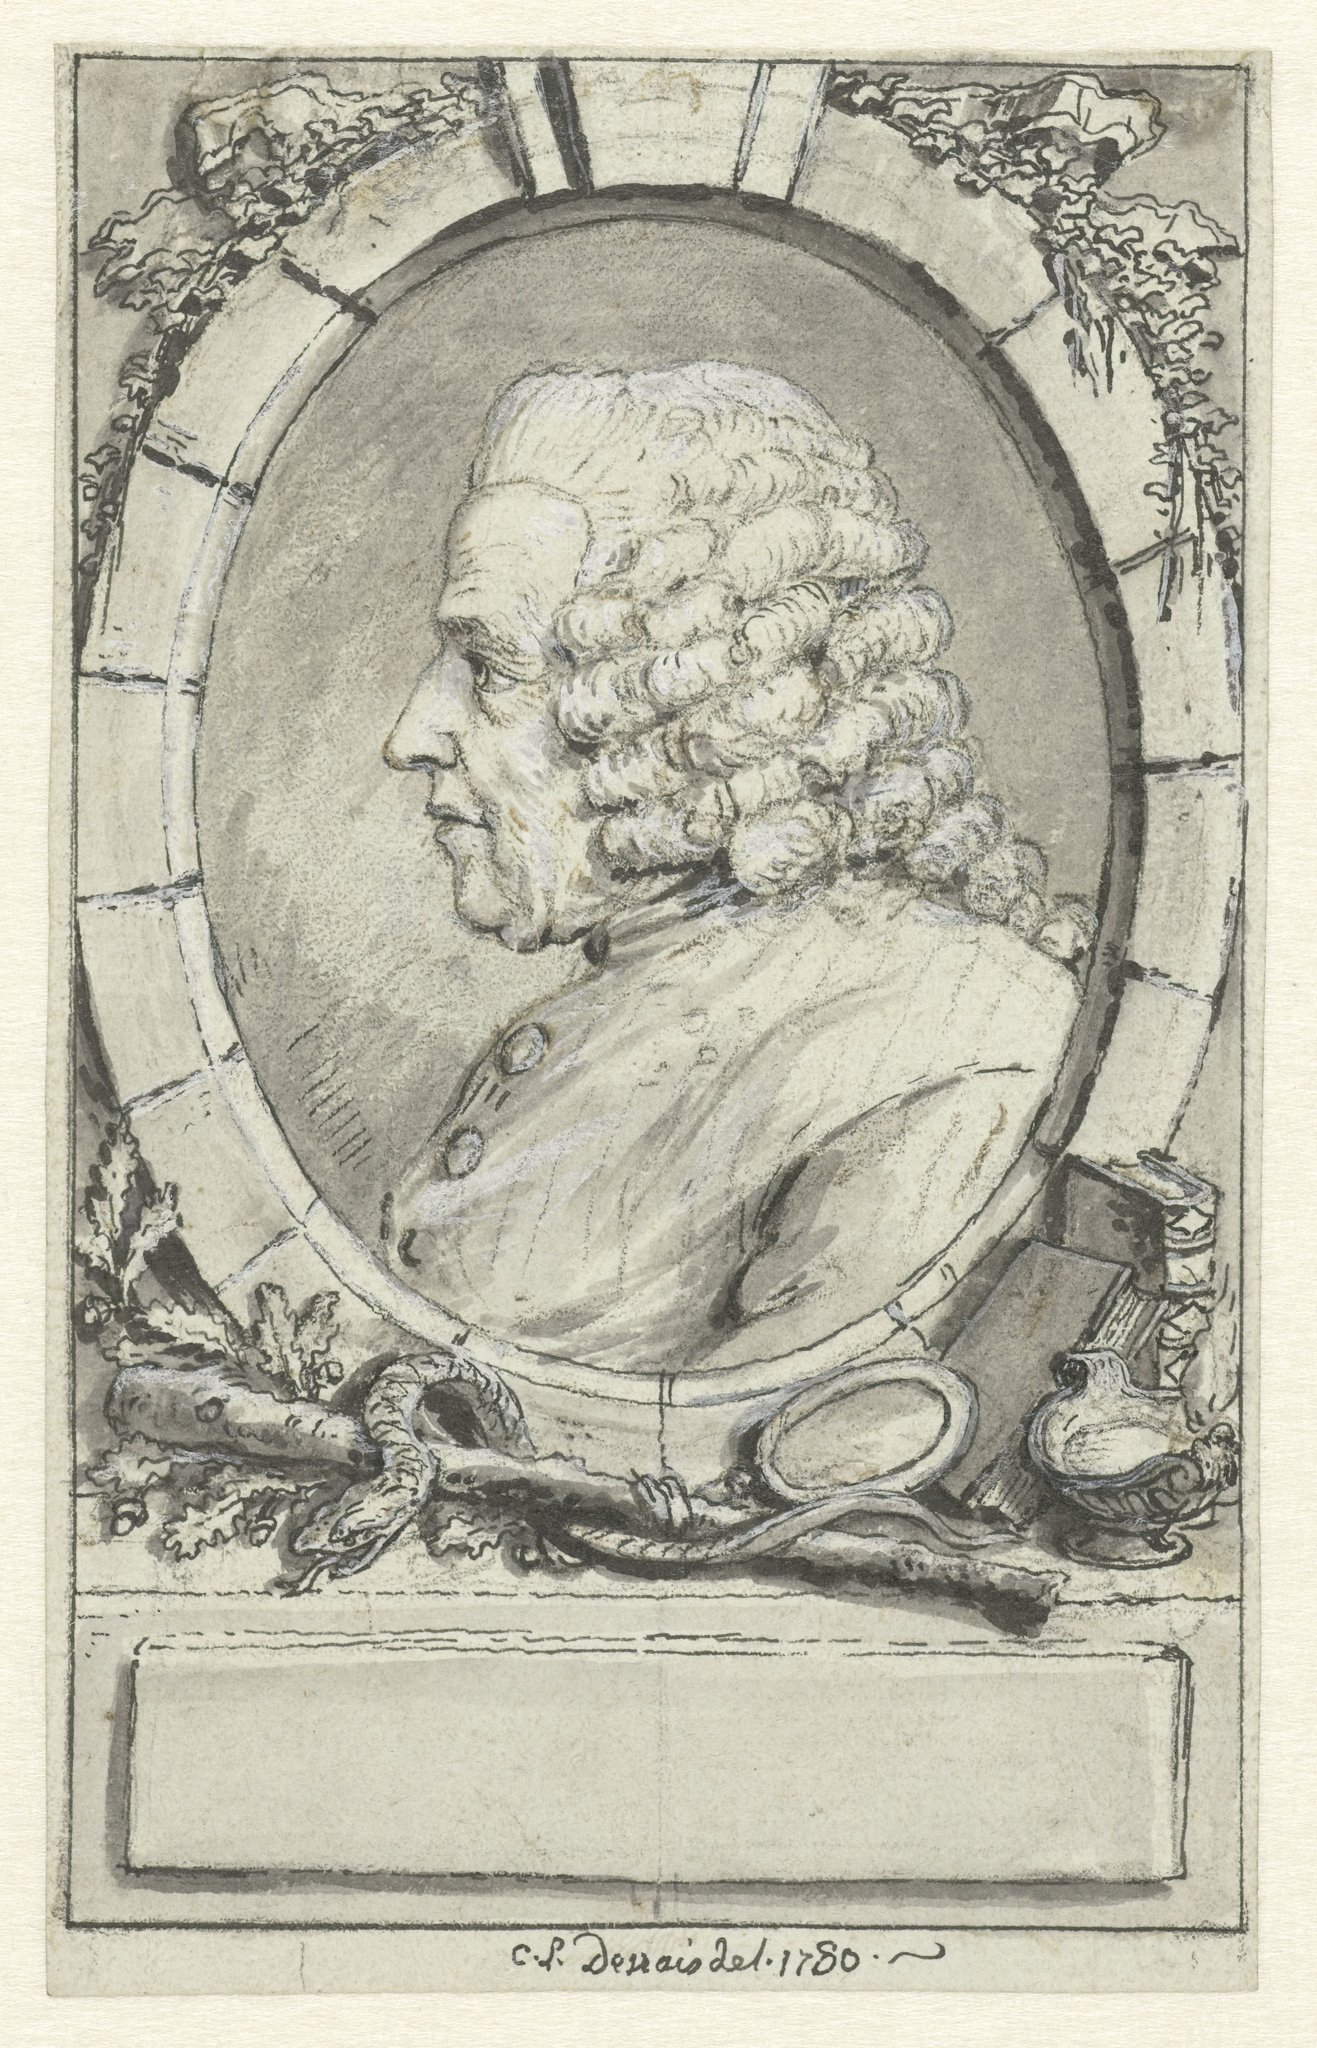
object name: drawing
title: Medaillonportret van een man, in randwerk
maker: claude louis desrais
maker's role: draughtsman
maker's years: 1746-1816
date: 1780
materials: chalk, ink, paper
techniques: brush, pen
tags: anonymous historical person portrayed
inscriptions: collector's mark, verso, lower centre: Lugt 2228, signature and date, recto, lower centre, pen and black ink: ‘C .L. Desrais. 1780.’, annotation: ‘1926 Lessine v’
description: Medaillonportret van een man, in randwerk, met naamplaat. Waarschijnlijk een geleerde, maar het preciese beroep is niet bekend. Mogelijk ontwerp voor een prent.